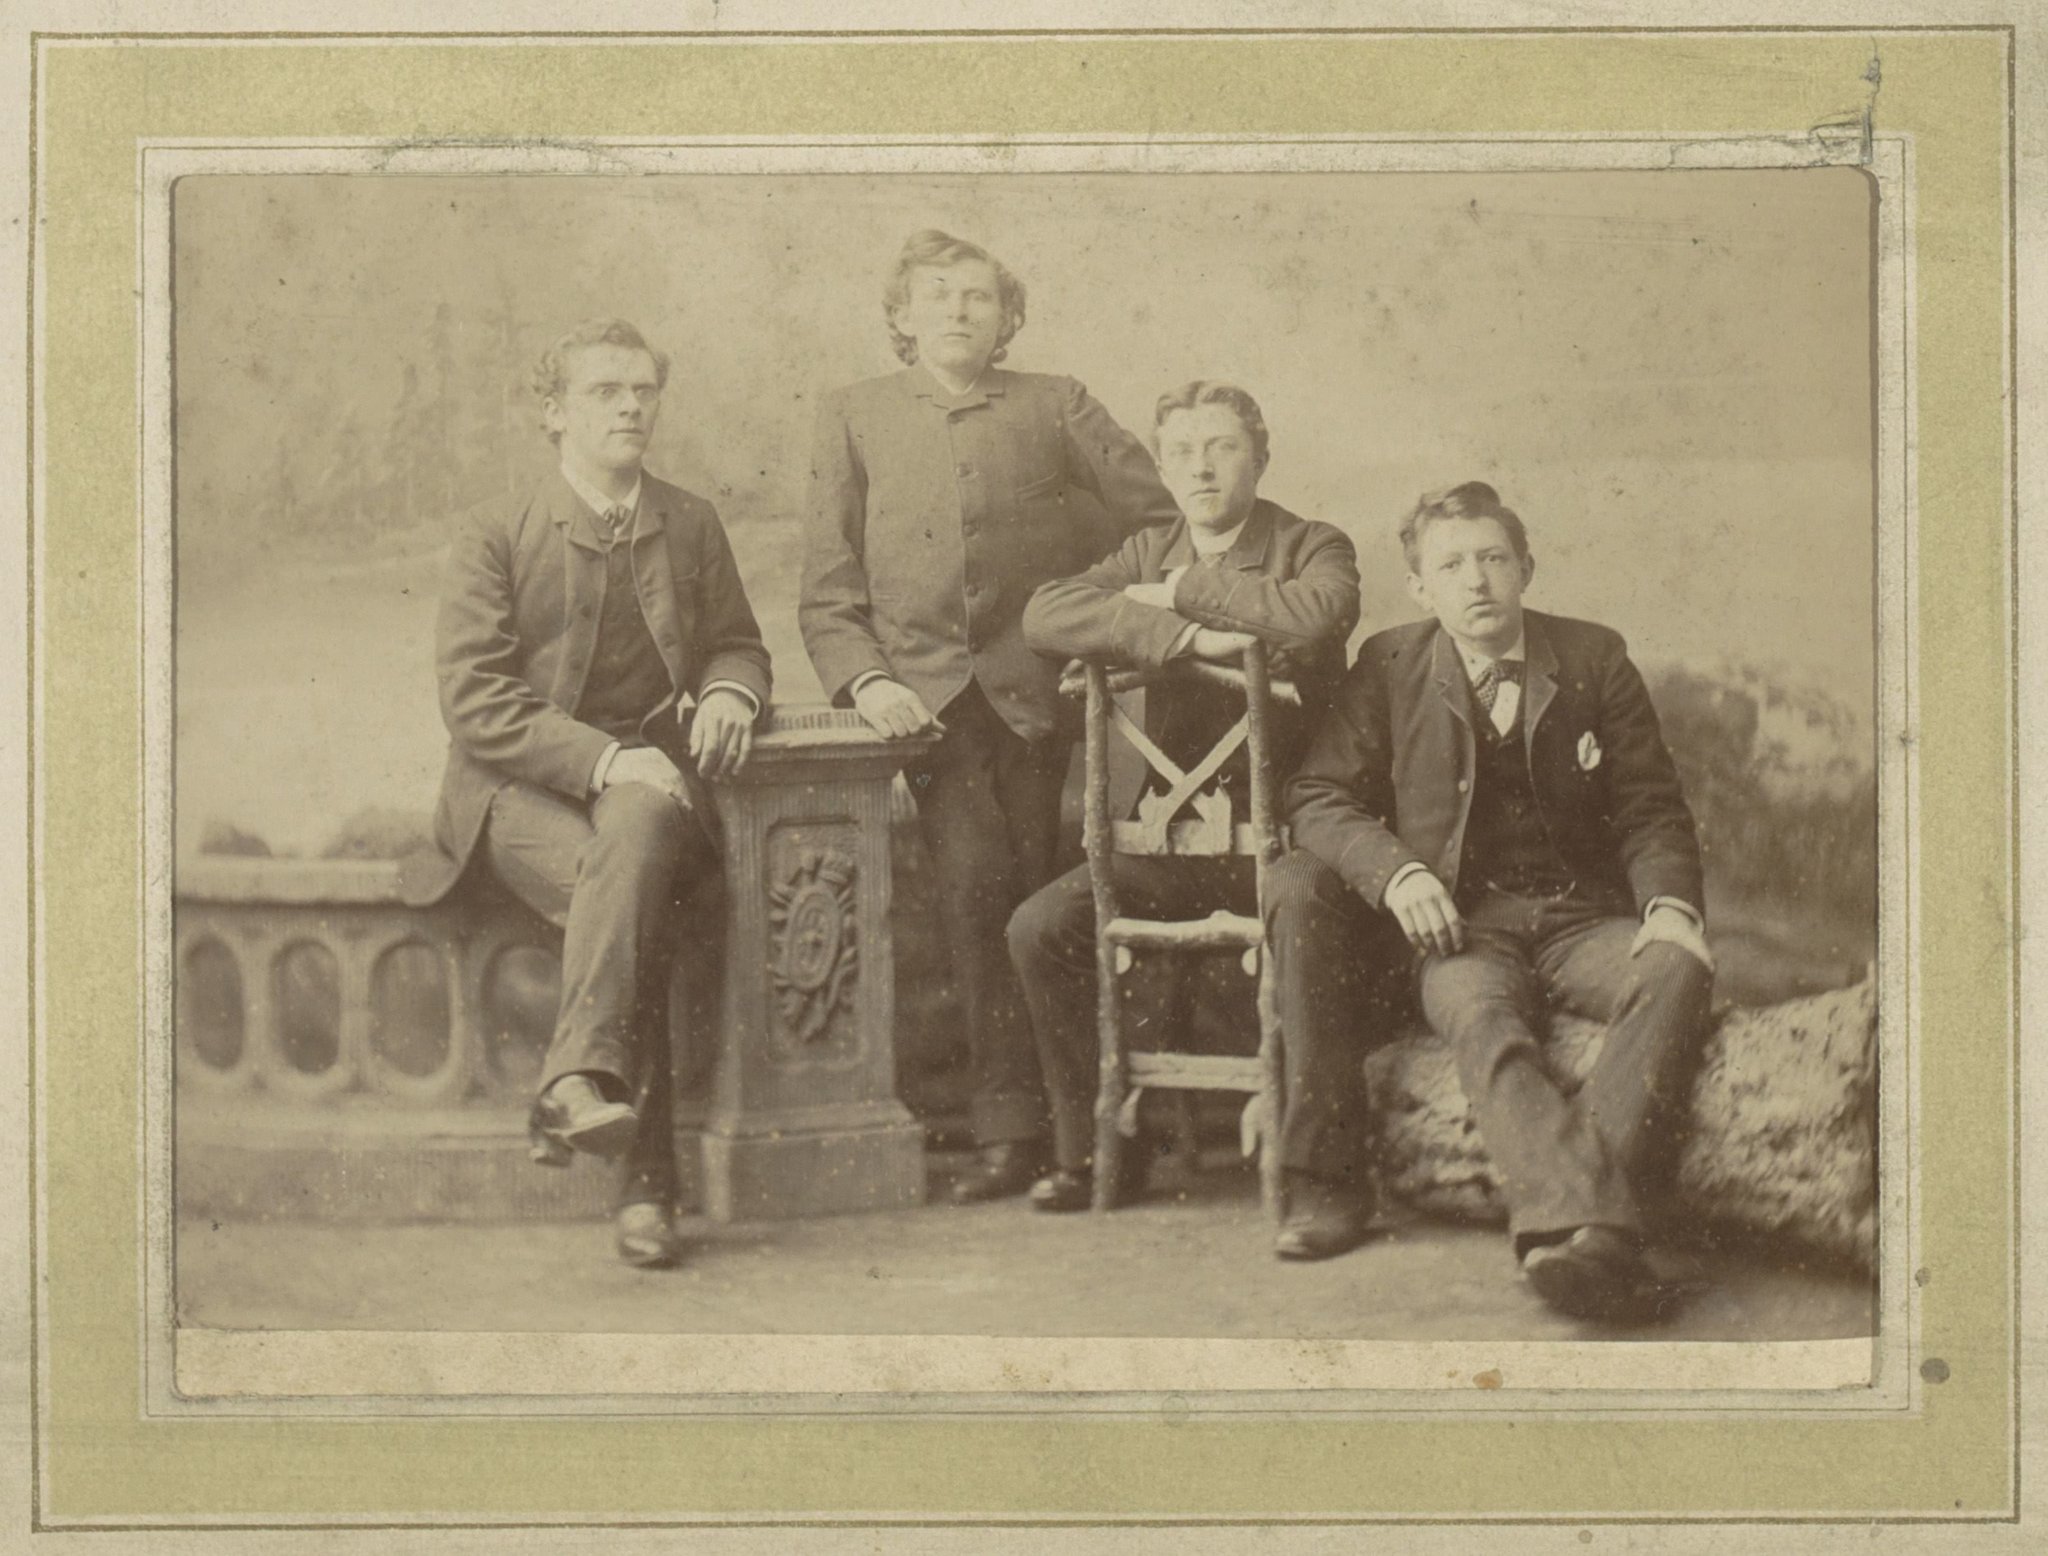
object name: photograph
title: Portret van vier jongemannen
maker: albert greiner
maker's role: fotograaf, fotostudio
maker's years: 1833-1890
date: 1870-1900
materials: cardboard, paper, photographic support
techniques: albumen print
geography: amsterdam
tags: studio requisites ~ photographer, clothing for the lower part of the body, adult man, historical persons, clothing for the upper part of the body, clothes, costume, amsterdam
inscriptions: address: ‘Amsterdam Nieuwendijk 89’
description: Onderdeel van Fotoalbum van een Nederlandse familie met 168 cartes-de-visite en kabinetfoto's.